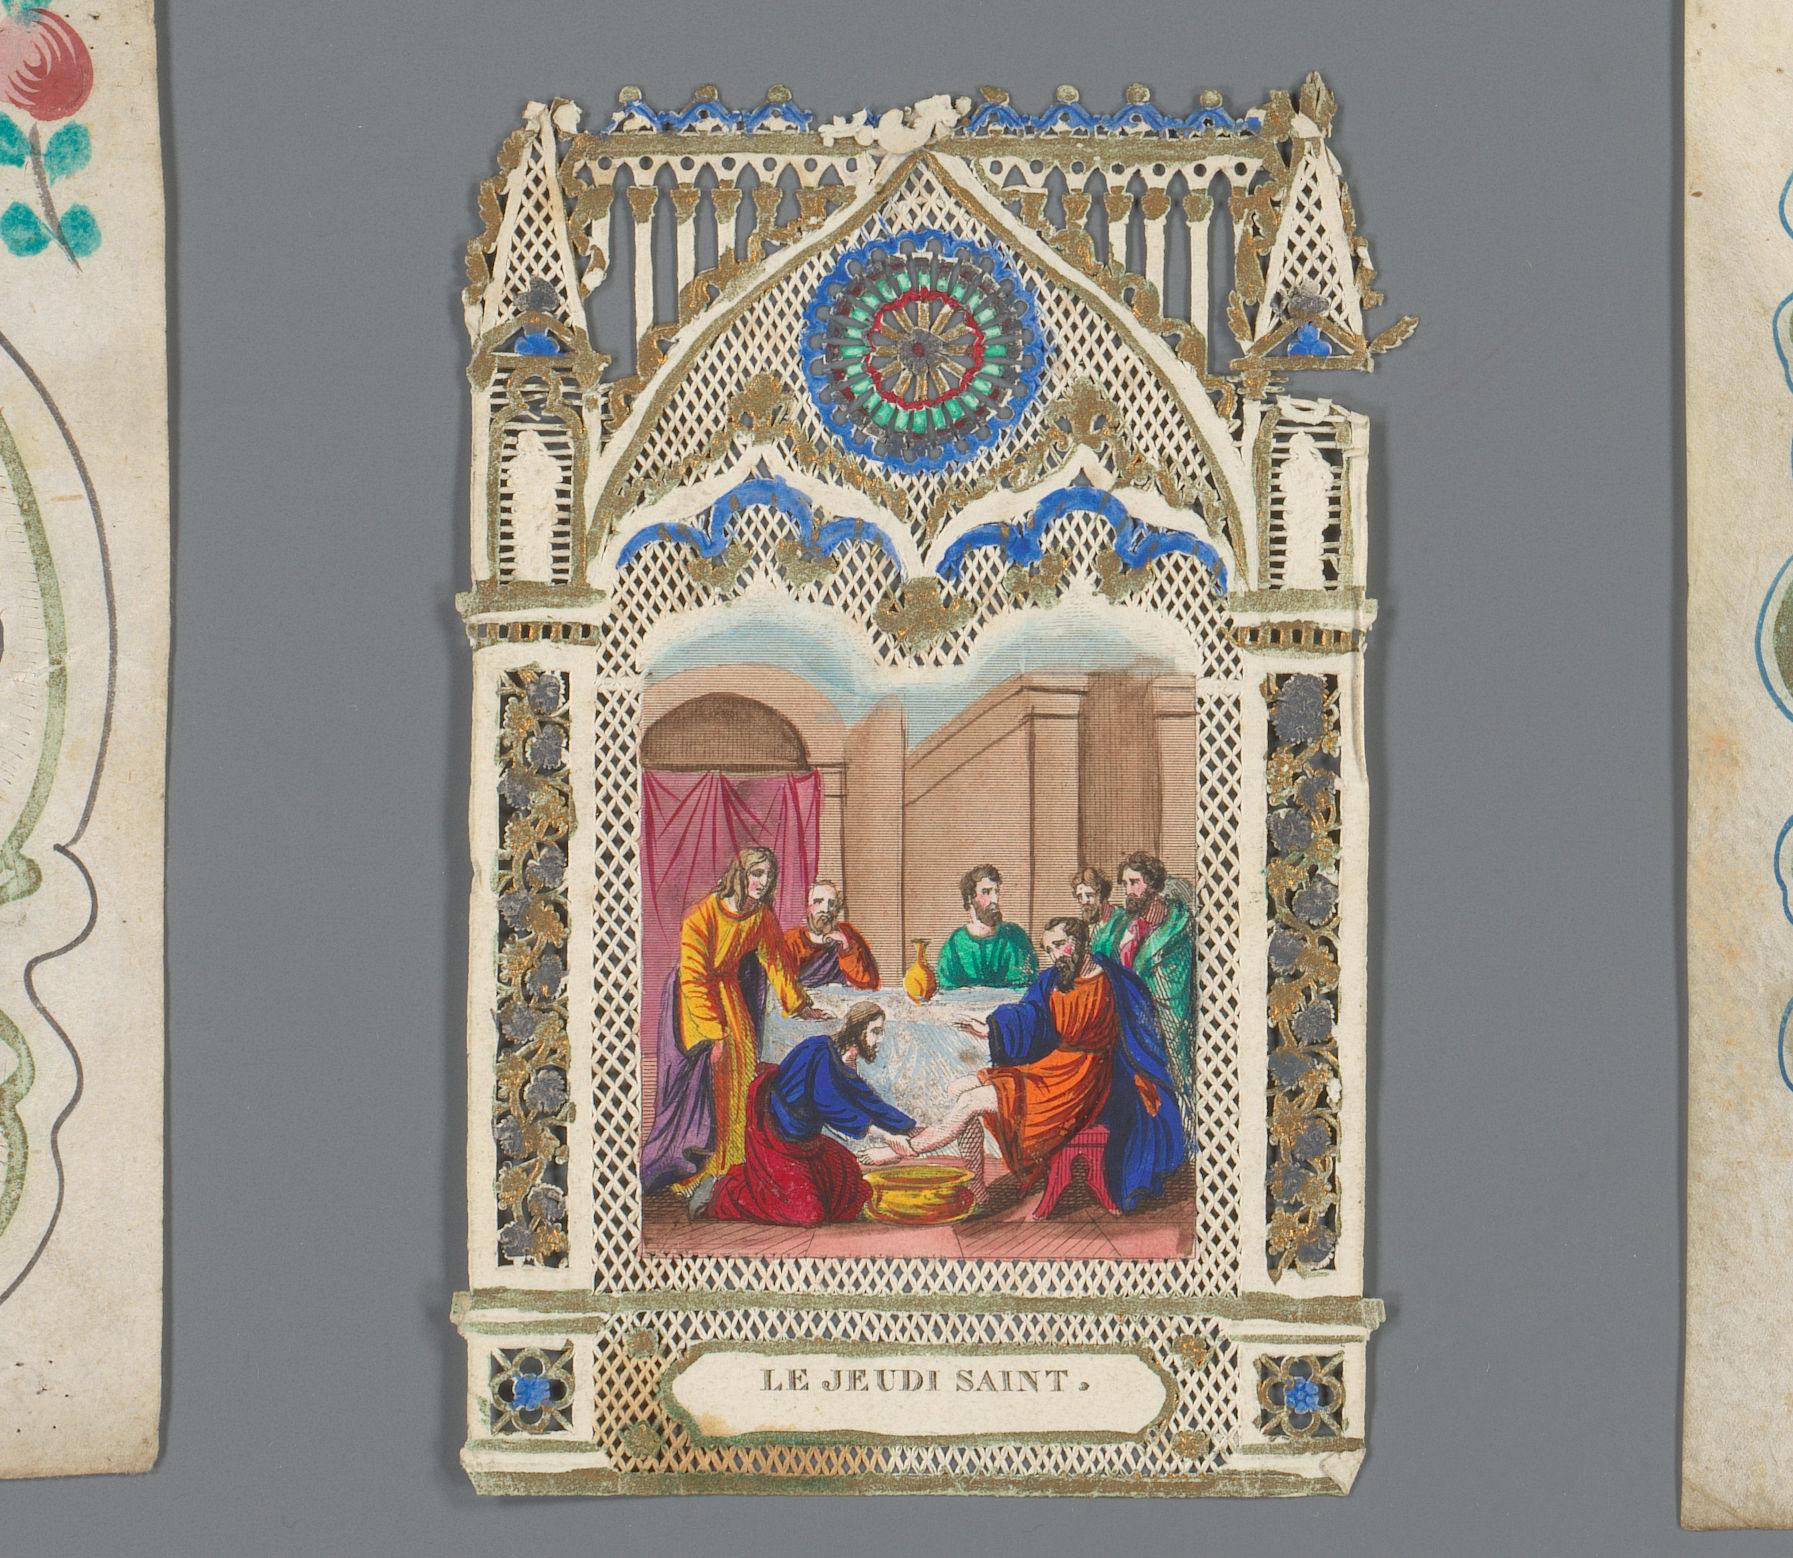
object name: cut paper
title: Kantprentje met de voetwassing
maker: Anonymous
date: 1750-1784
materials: paper, watercolor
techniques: cutting, etching, snipping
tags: christ washes peter's feet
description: Voorstelling van de voetwassing, in een omlijsting dat door snijwerk en knipwerk de vorm van kerkarchitectuur heeft gekregen.